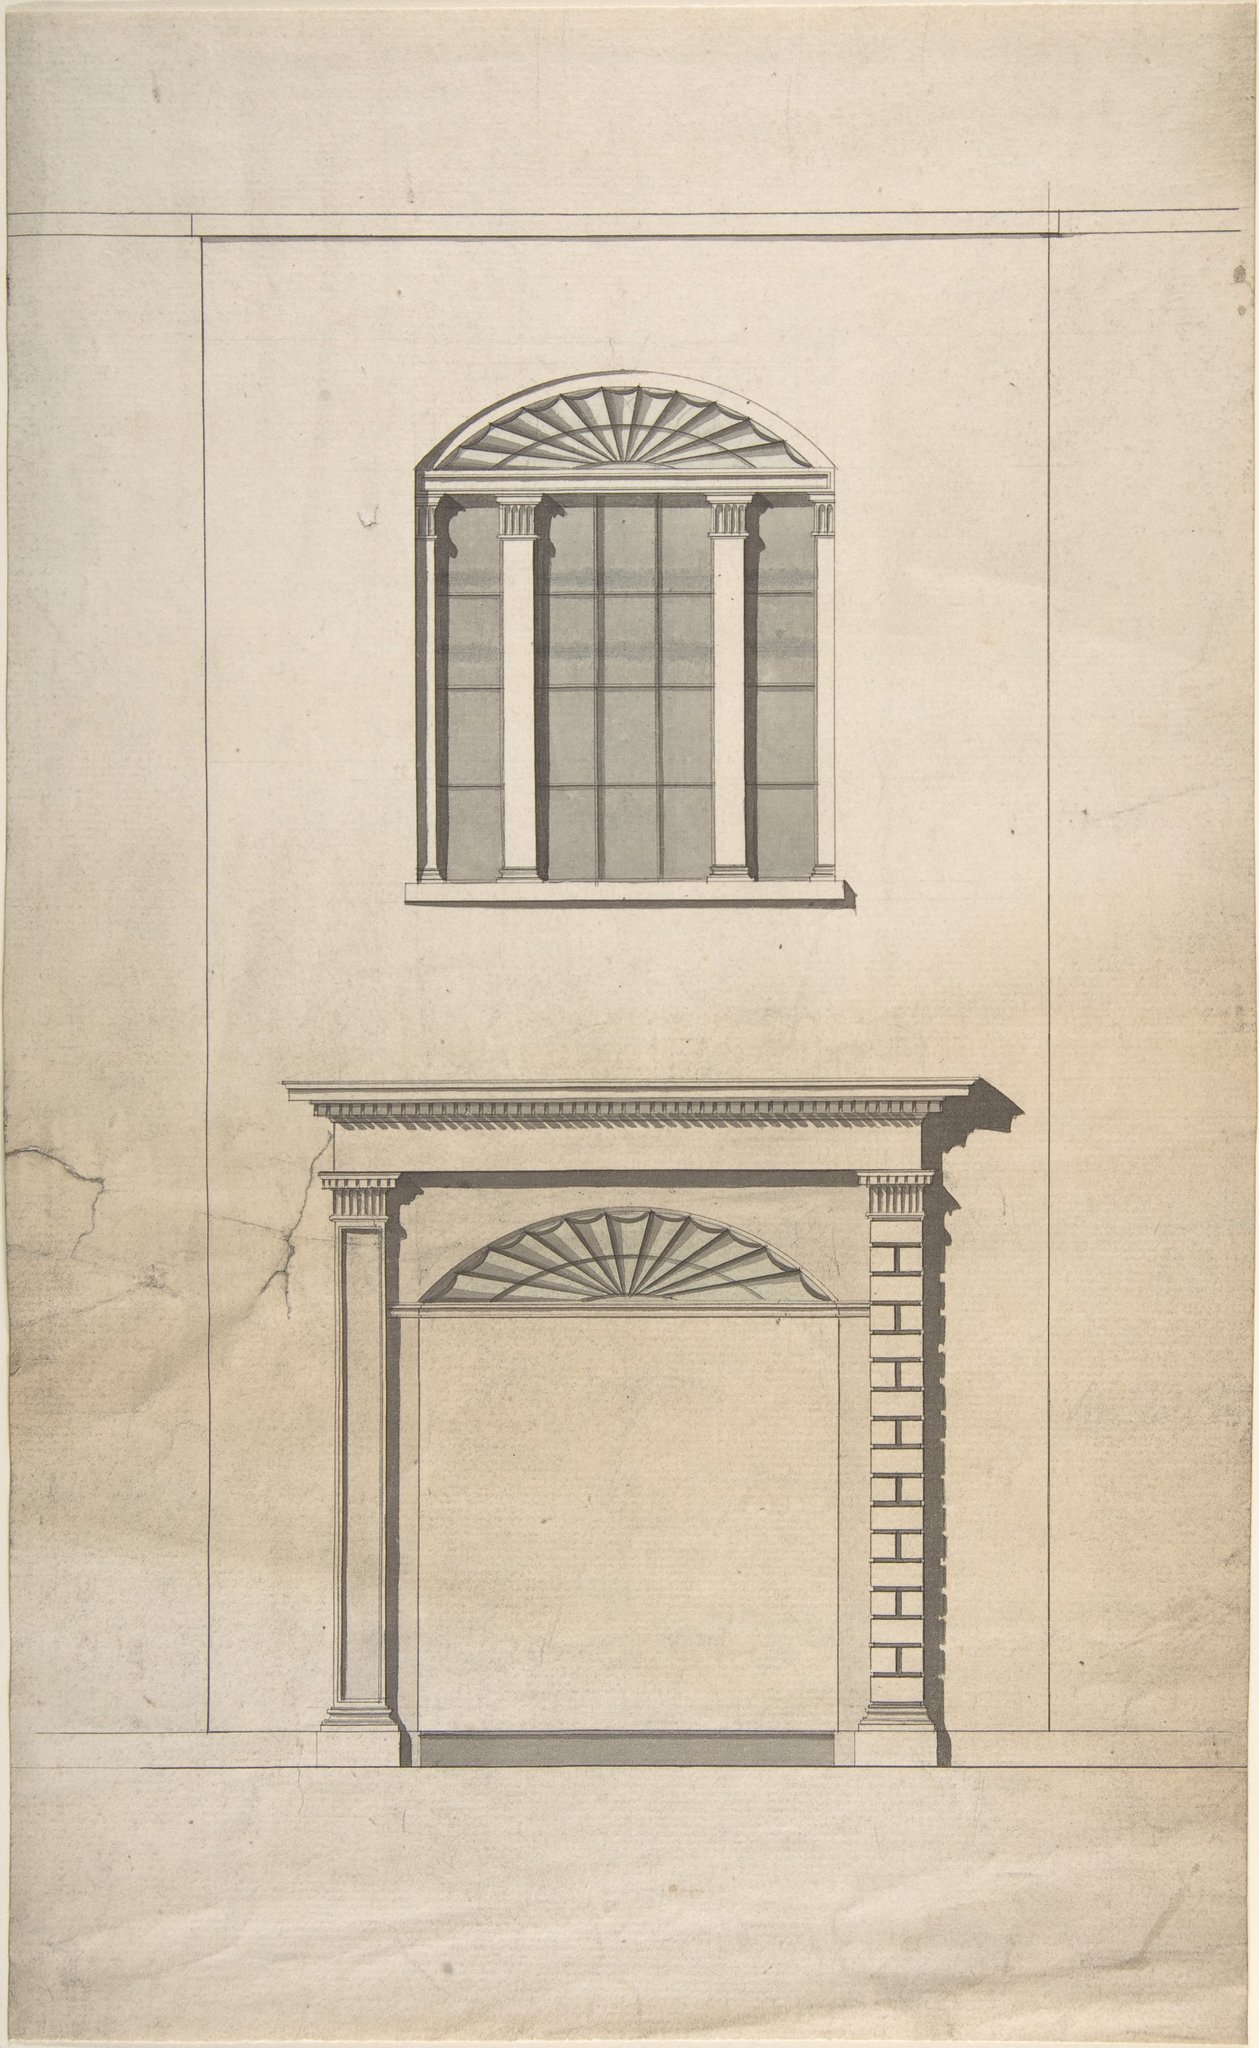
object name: drawing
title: Design for a Fireplace and Window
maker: anonymous, british, 18th century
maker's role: artist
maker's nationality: british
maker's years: 1700-1800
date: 1701-1800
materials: ink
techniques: brush, pen, wash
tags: architecture,fireplaces,windows